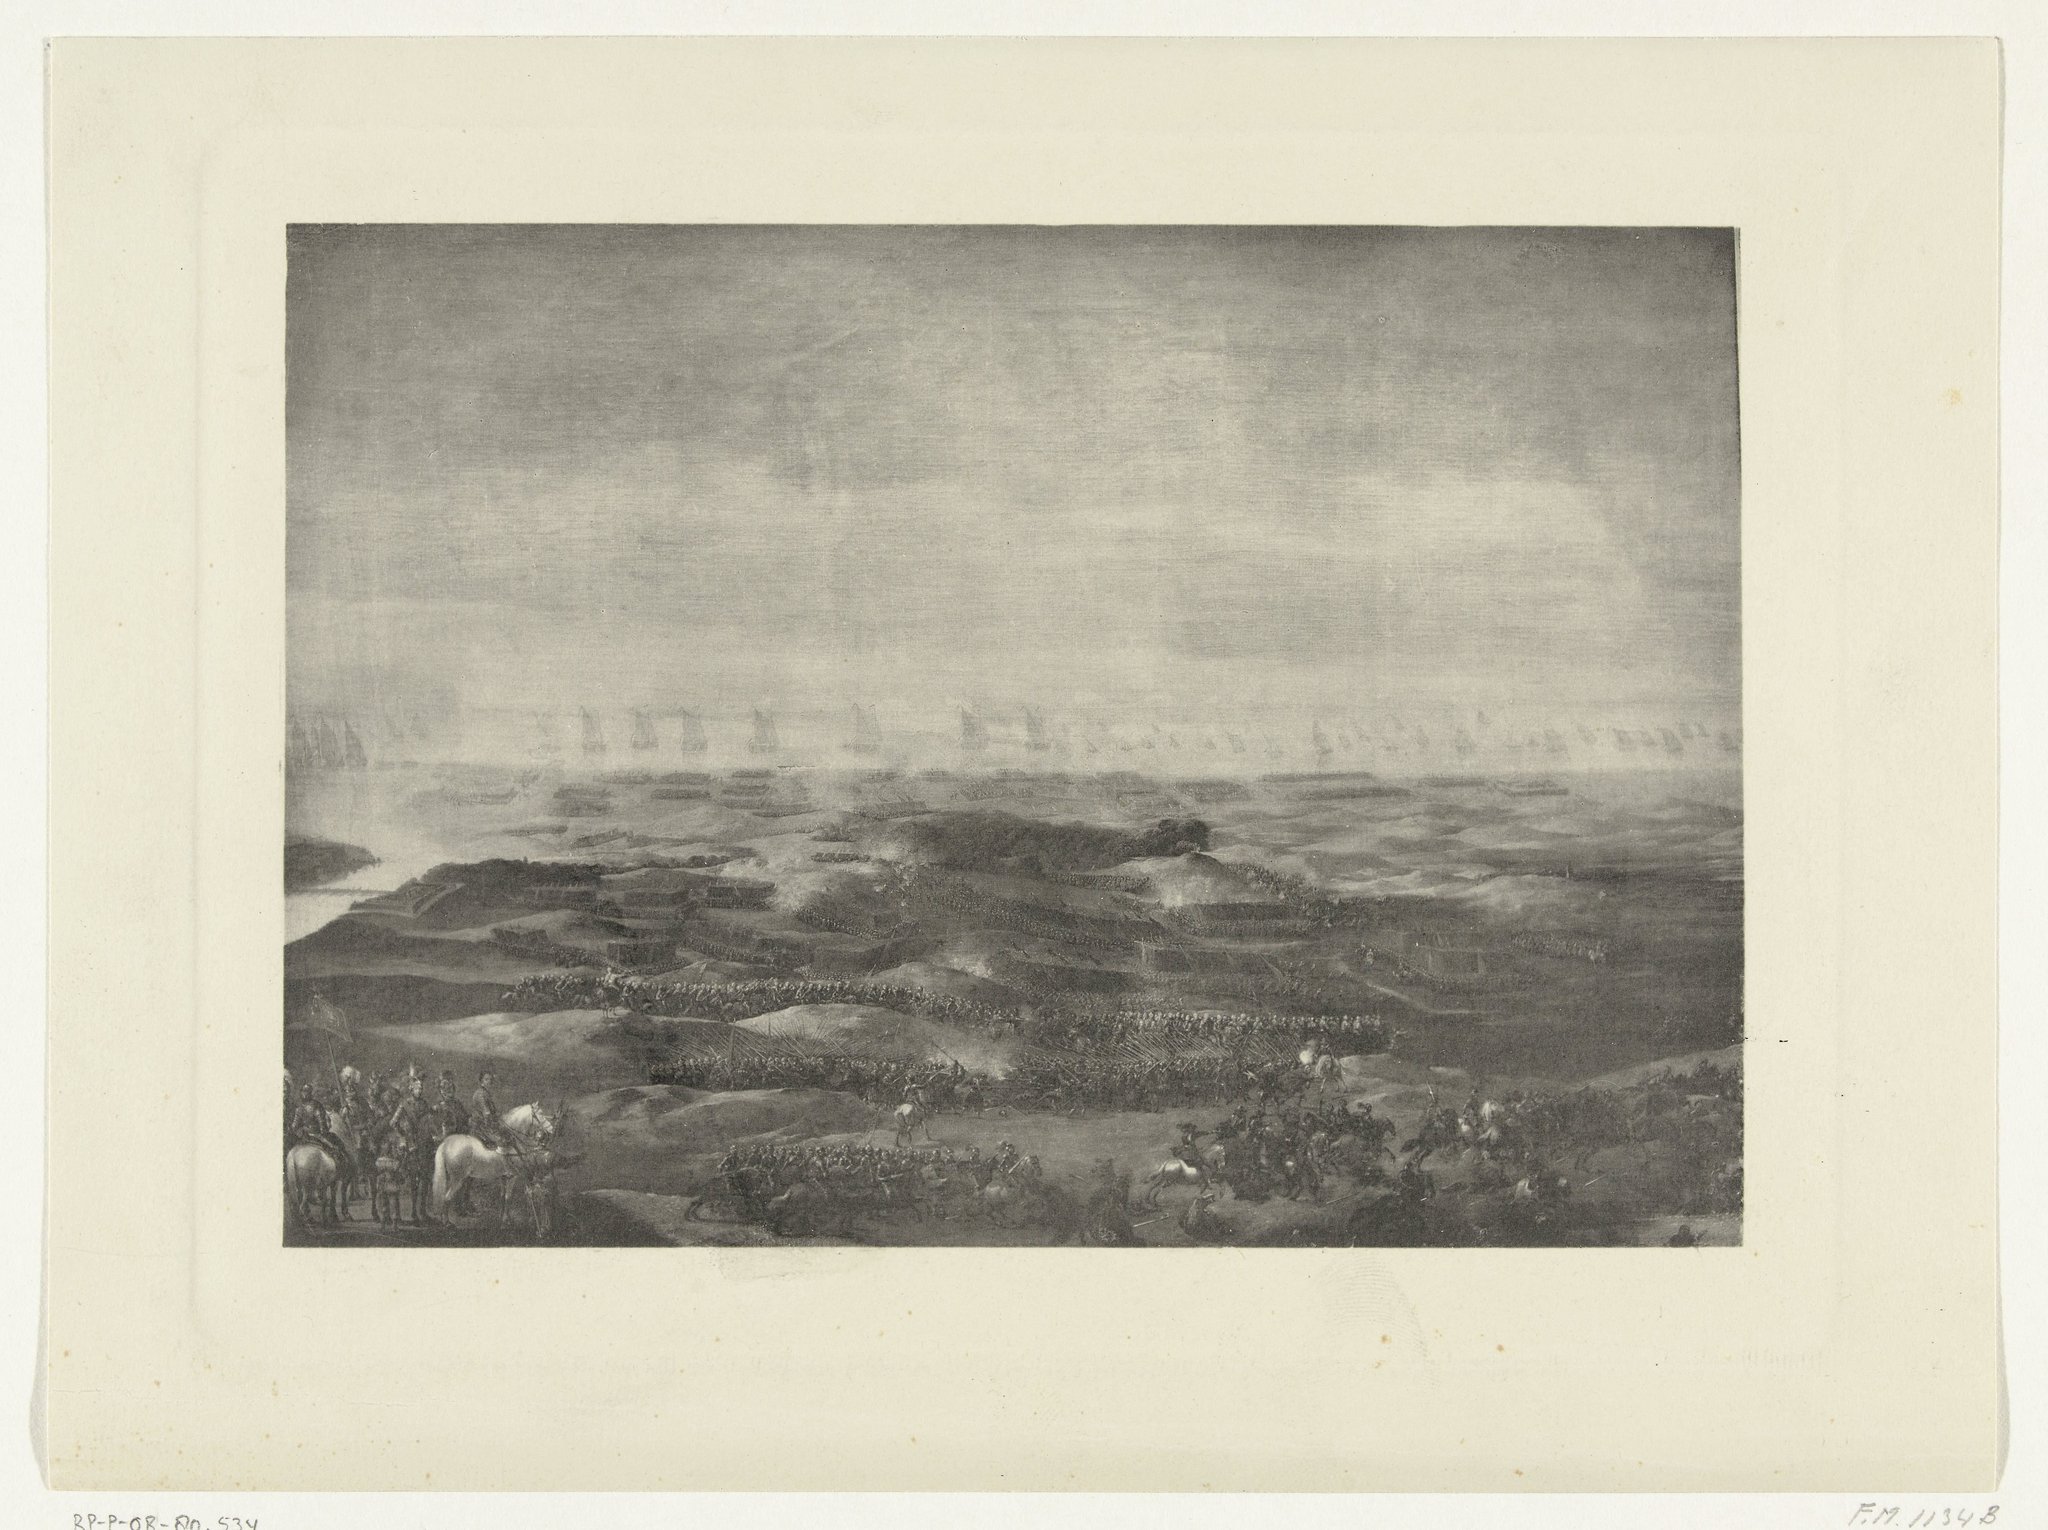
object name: historieplaat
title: Schilderij van de slag bij Nieuwpoort, 1600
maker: Anonymous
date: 1880-1950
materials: paper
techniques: printing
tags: maurice (prince of orange), battle (+ land forces), battle of nieuwpoort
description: Foto van het schilderij in de collectie van het Tiroler Landesmuseum Ferdinandeum, Innsbruck. Niet in Frederik Muller; door het RPK toegevoegd nummer.